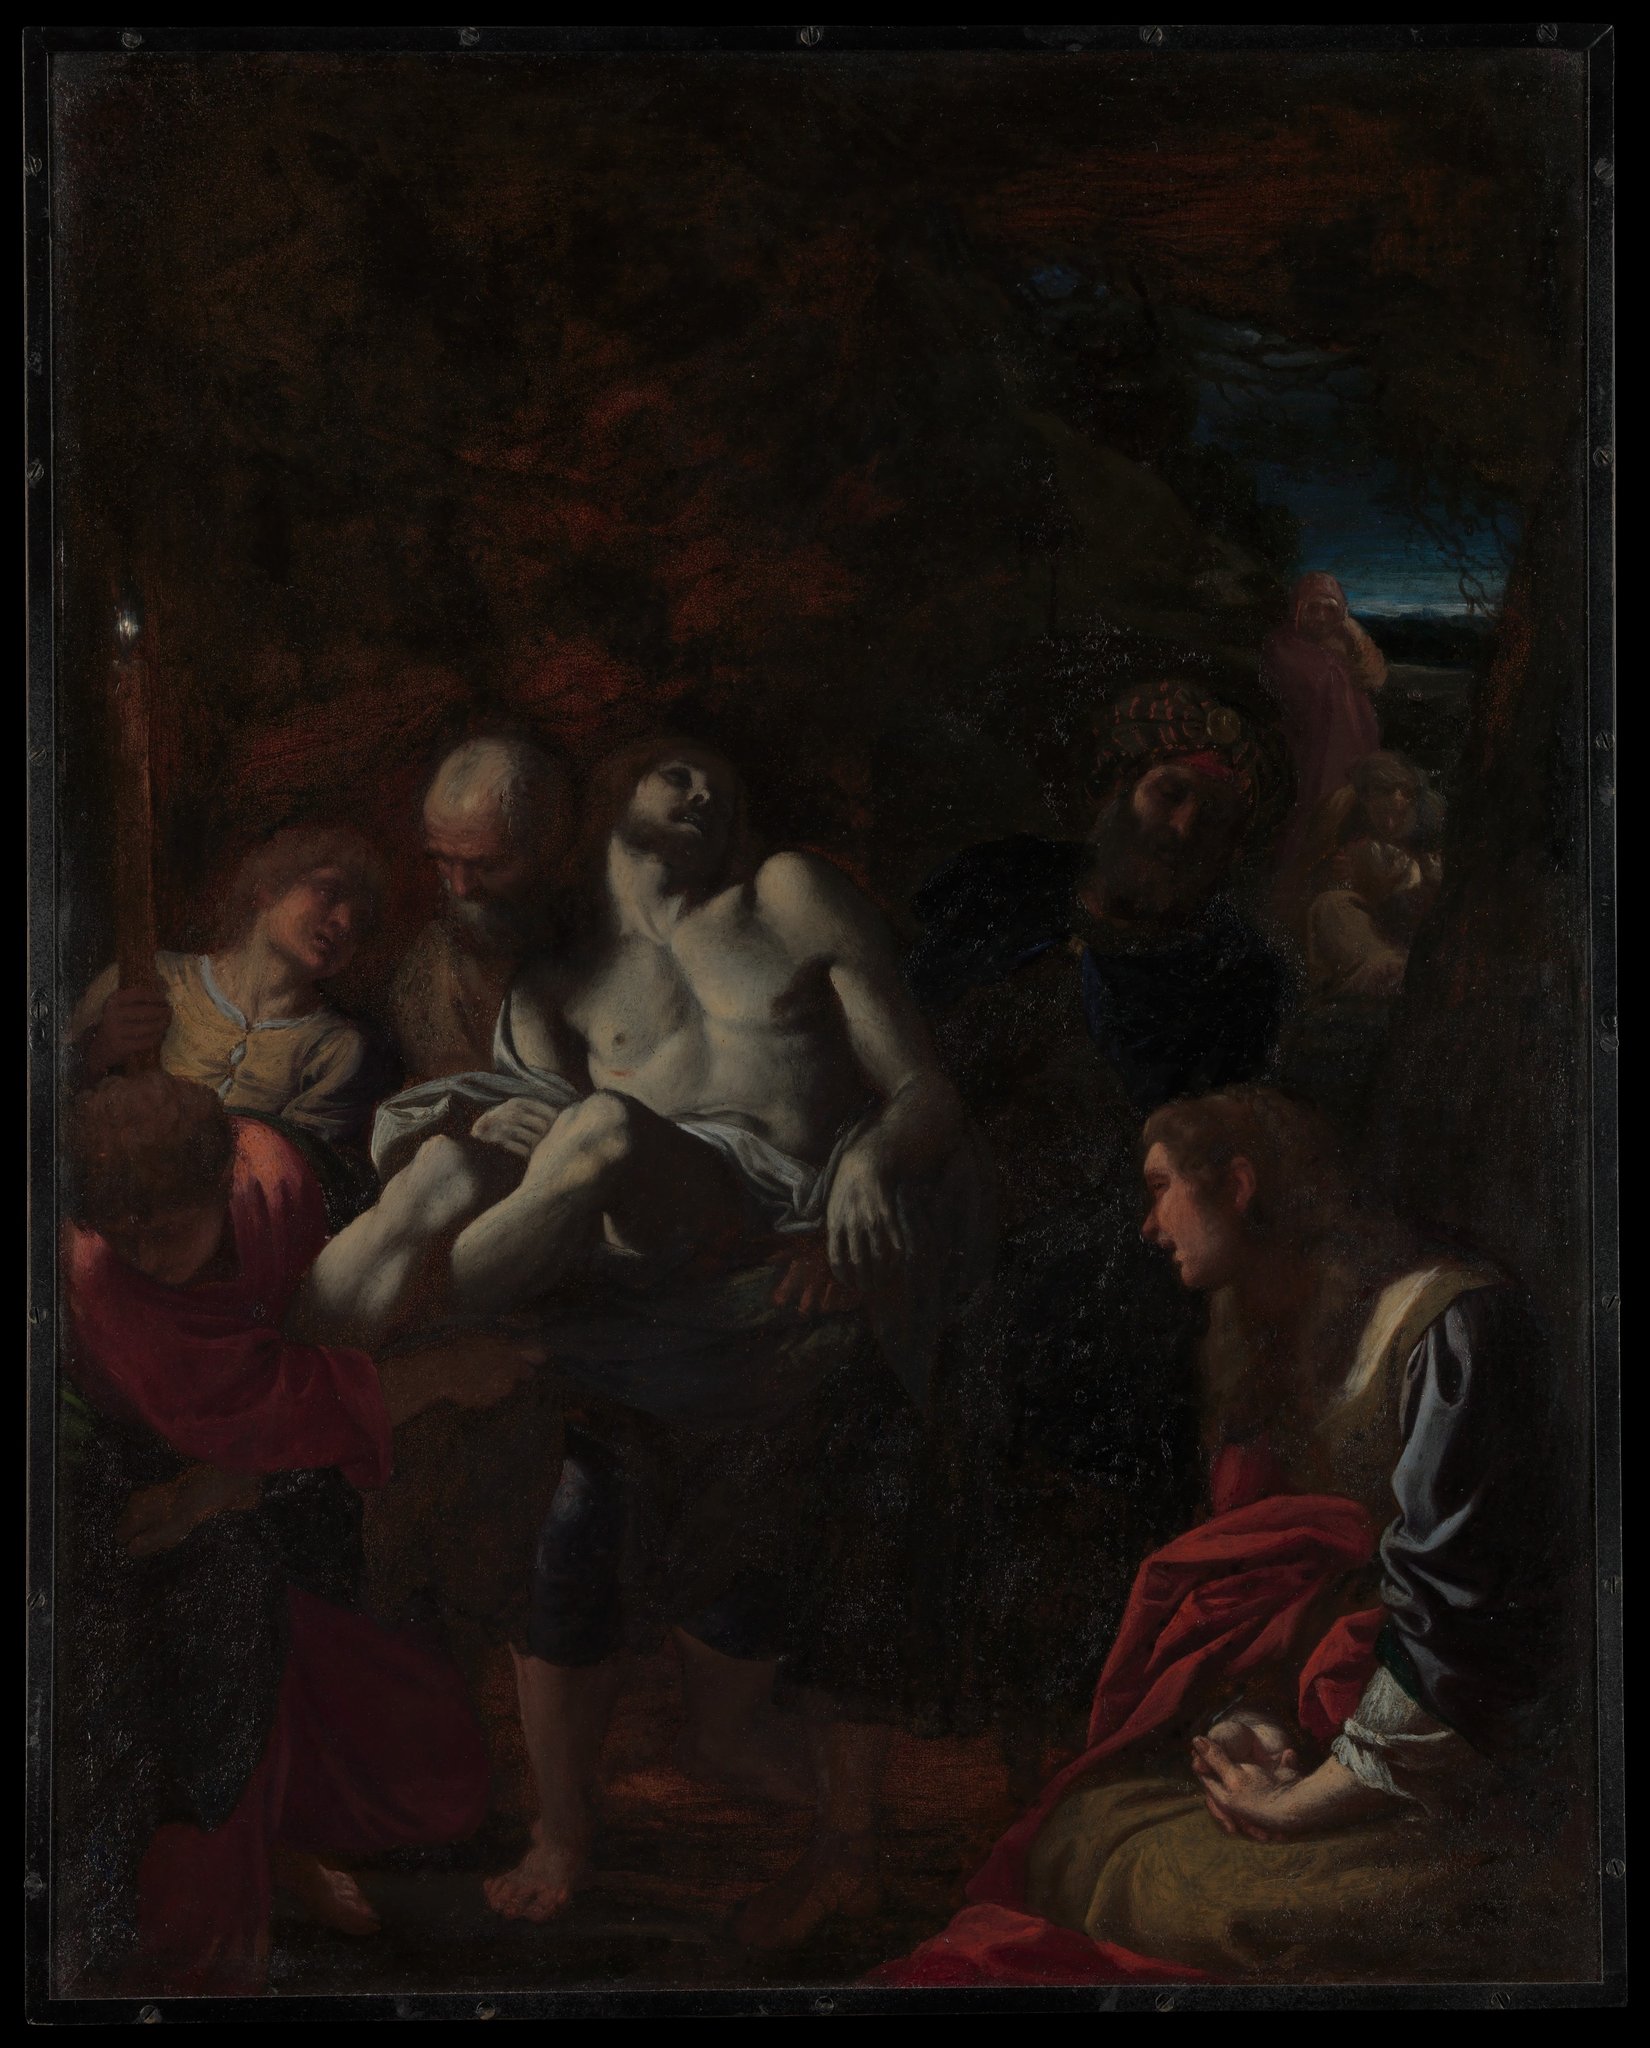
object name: painting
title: The Burial of Christ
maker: annibale carracci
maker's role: artist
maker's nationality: italian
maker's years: 1560-1609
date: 1595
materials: copper, oil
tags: sadness,christ,mary magdalene,entombment